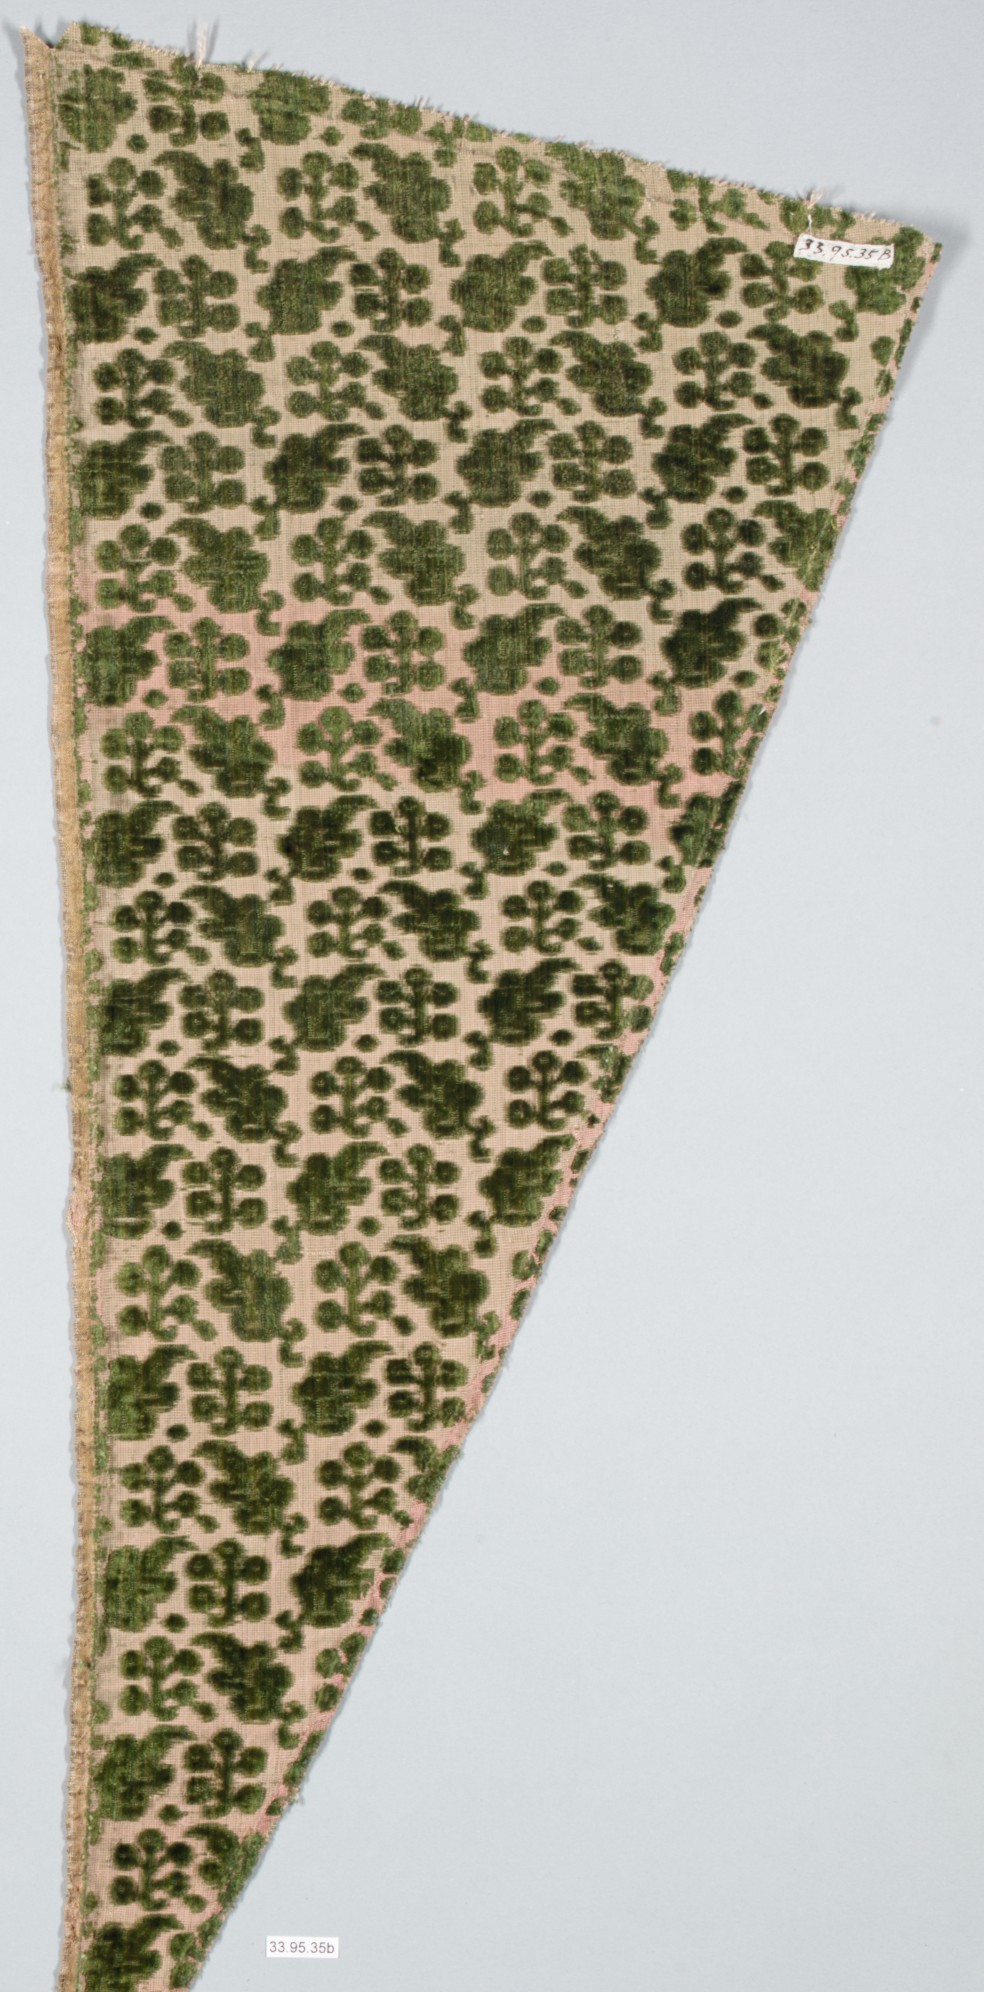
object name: piece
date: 1501-1700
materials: silk